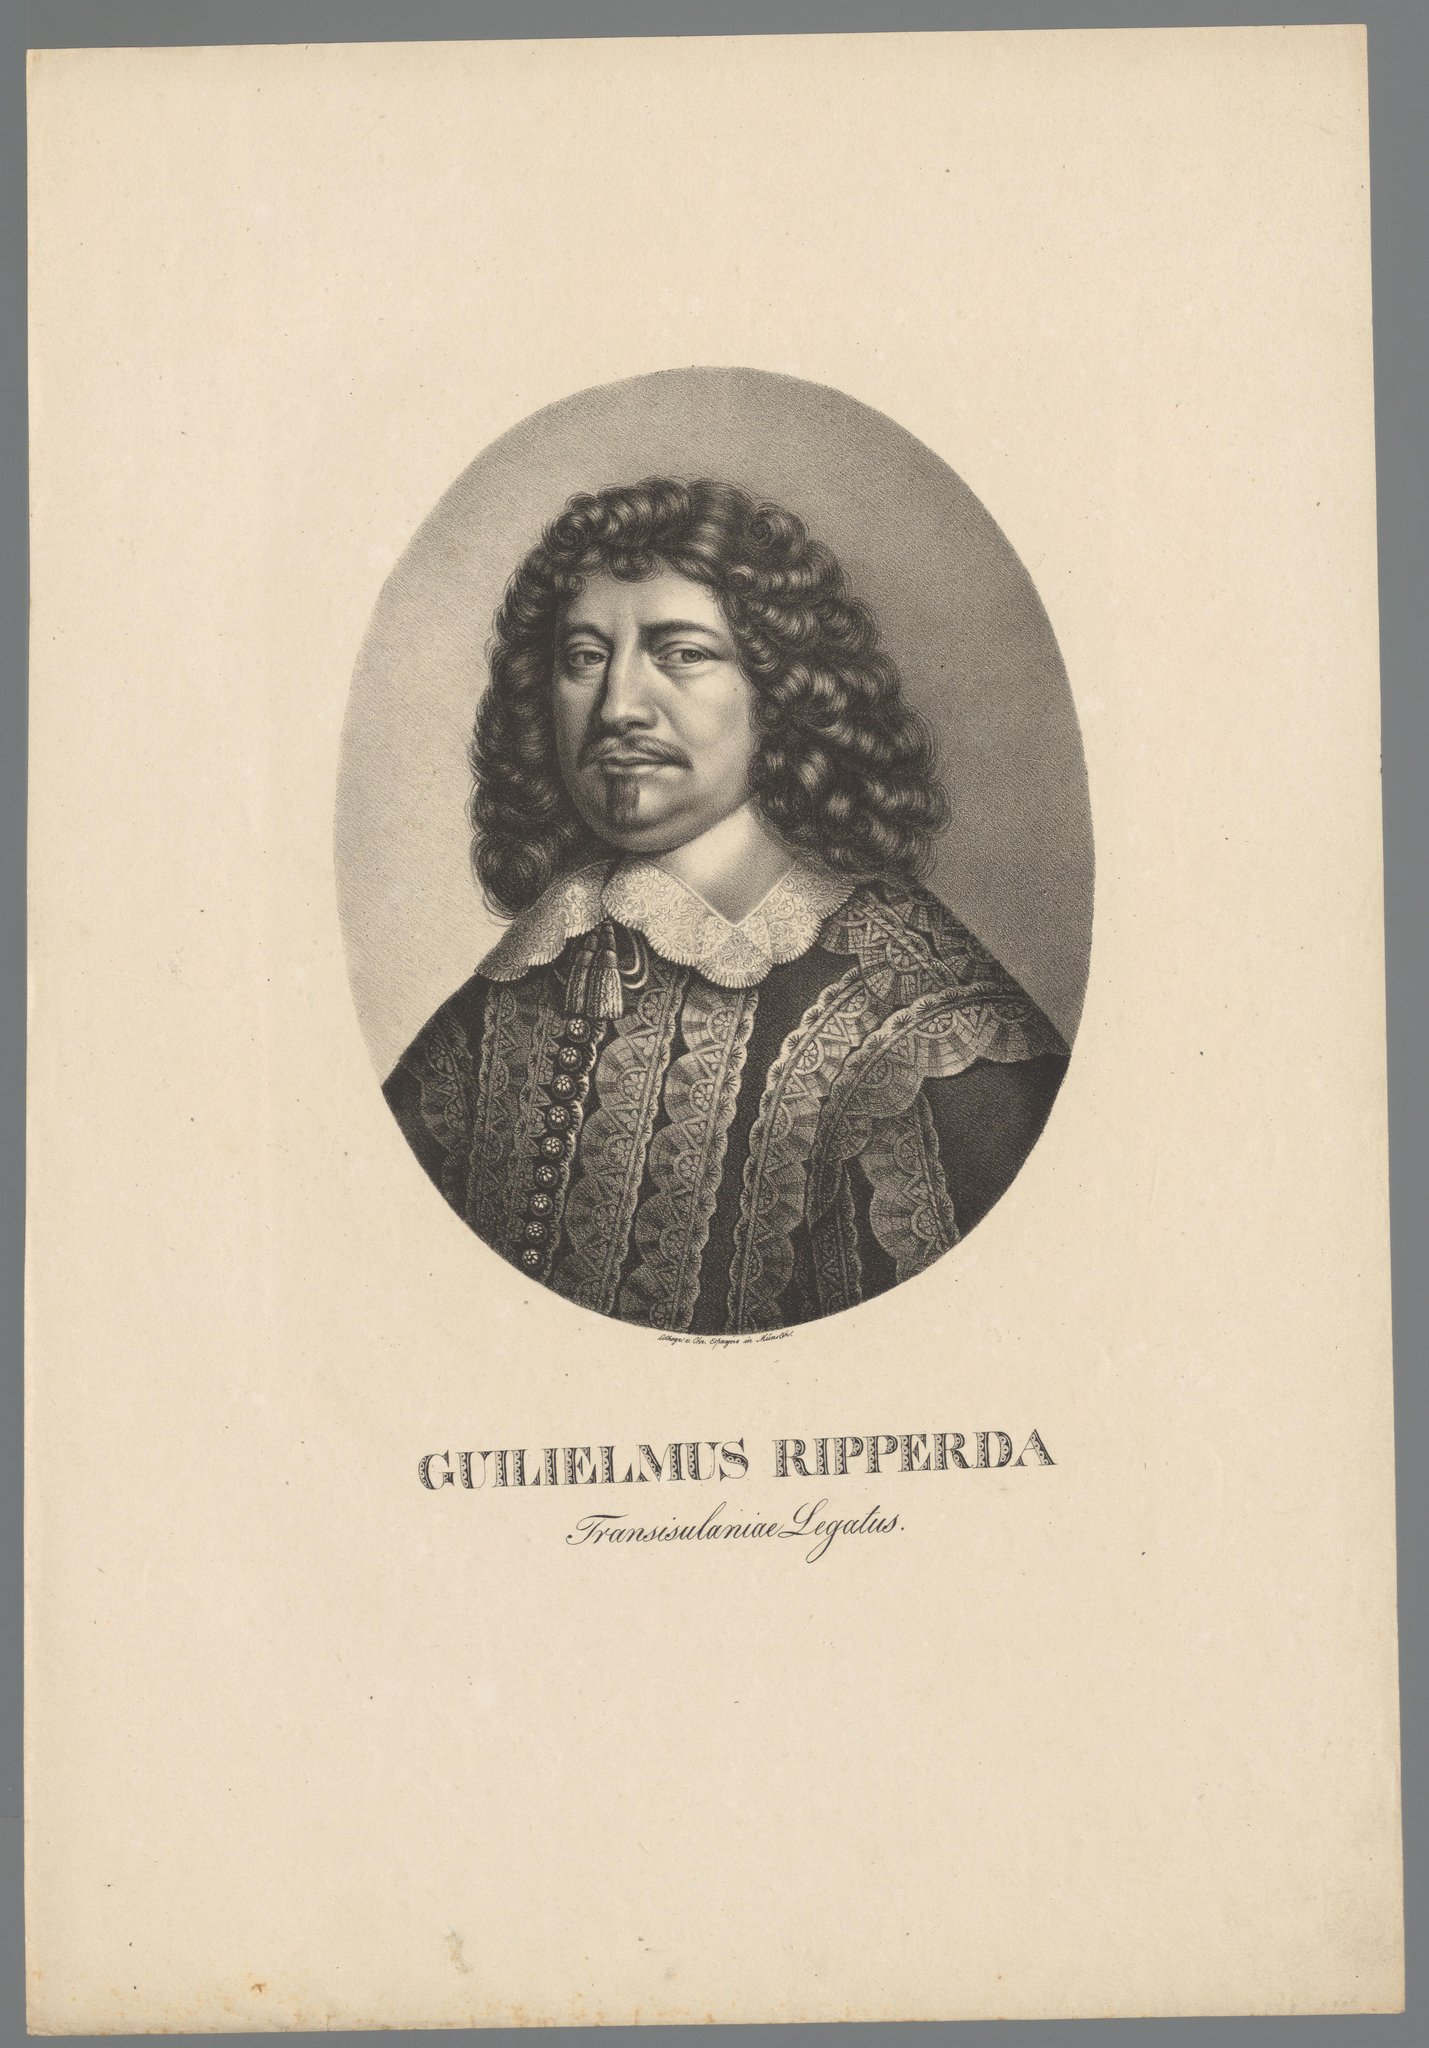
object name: print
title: Portret van Willem van Ripperda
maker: christian espagne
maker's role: print maker, printer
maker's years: 1794-1838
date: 1824-1827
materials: paper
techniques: lithograph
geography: munster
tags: adult man, historical persons, beard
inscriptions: collector's mark: Lugt 2228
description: Prent uit: Bildnisse der beim westfälischen Friedensschluß zu Münster und Osnabrück versammelt gewesenen Gesandten. Münster: Christian Espagne, [1824-1827]. Deze publicatie bevat een onbekend aantal lithografieën, die in afleveringen verschenen als illustratie bij de tekst.